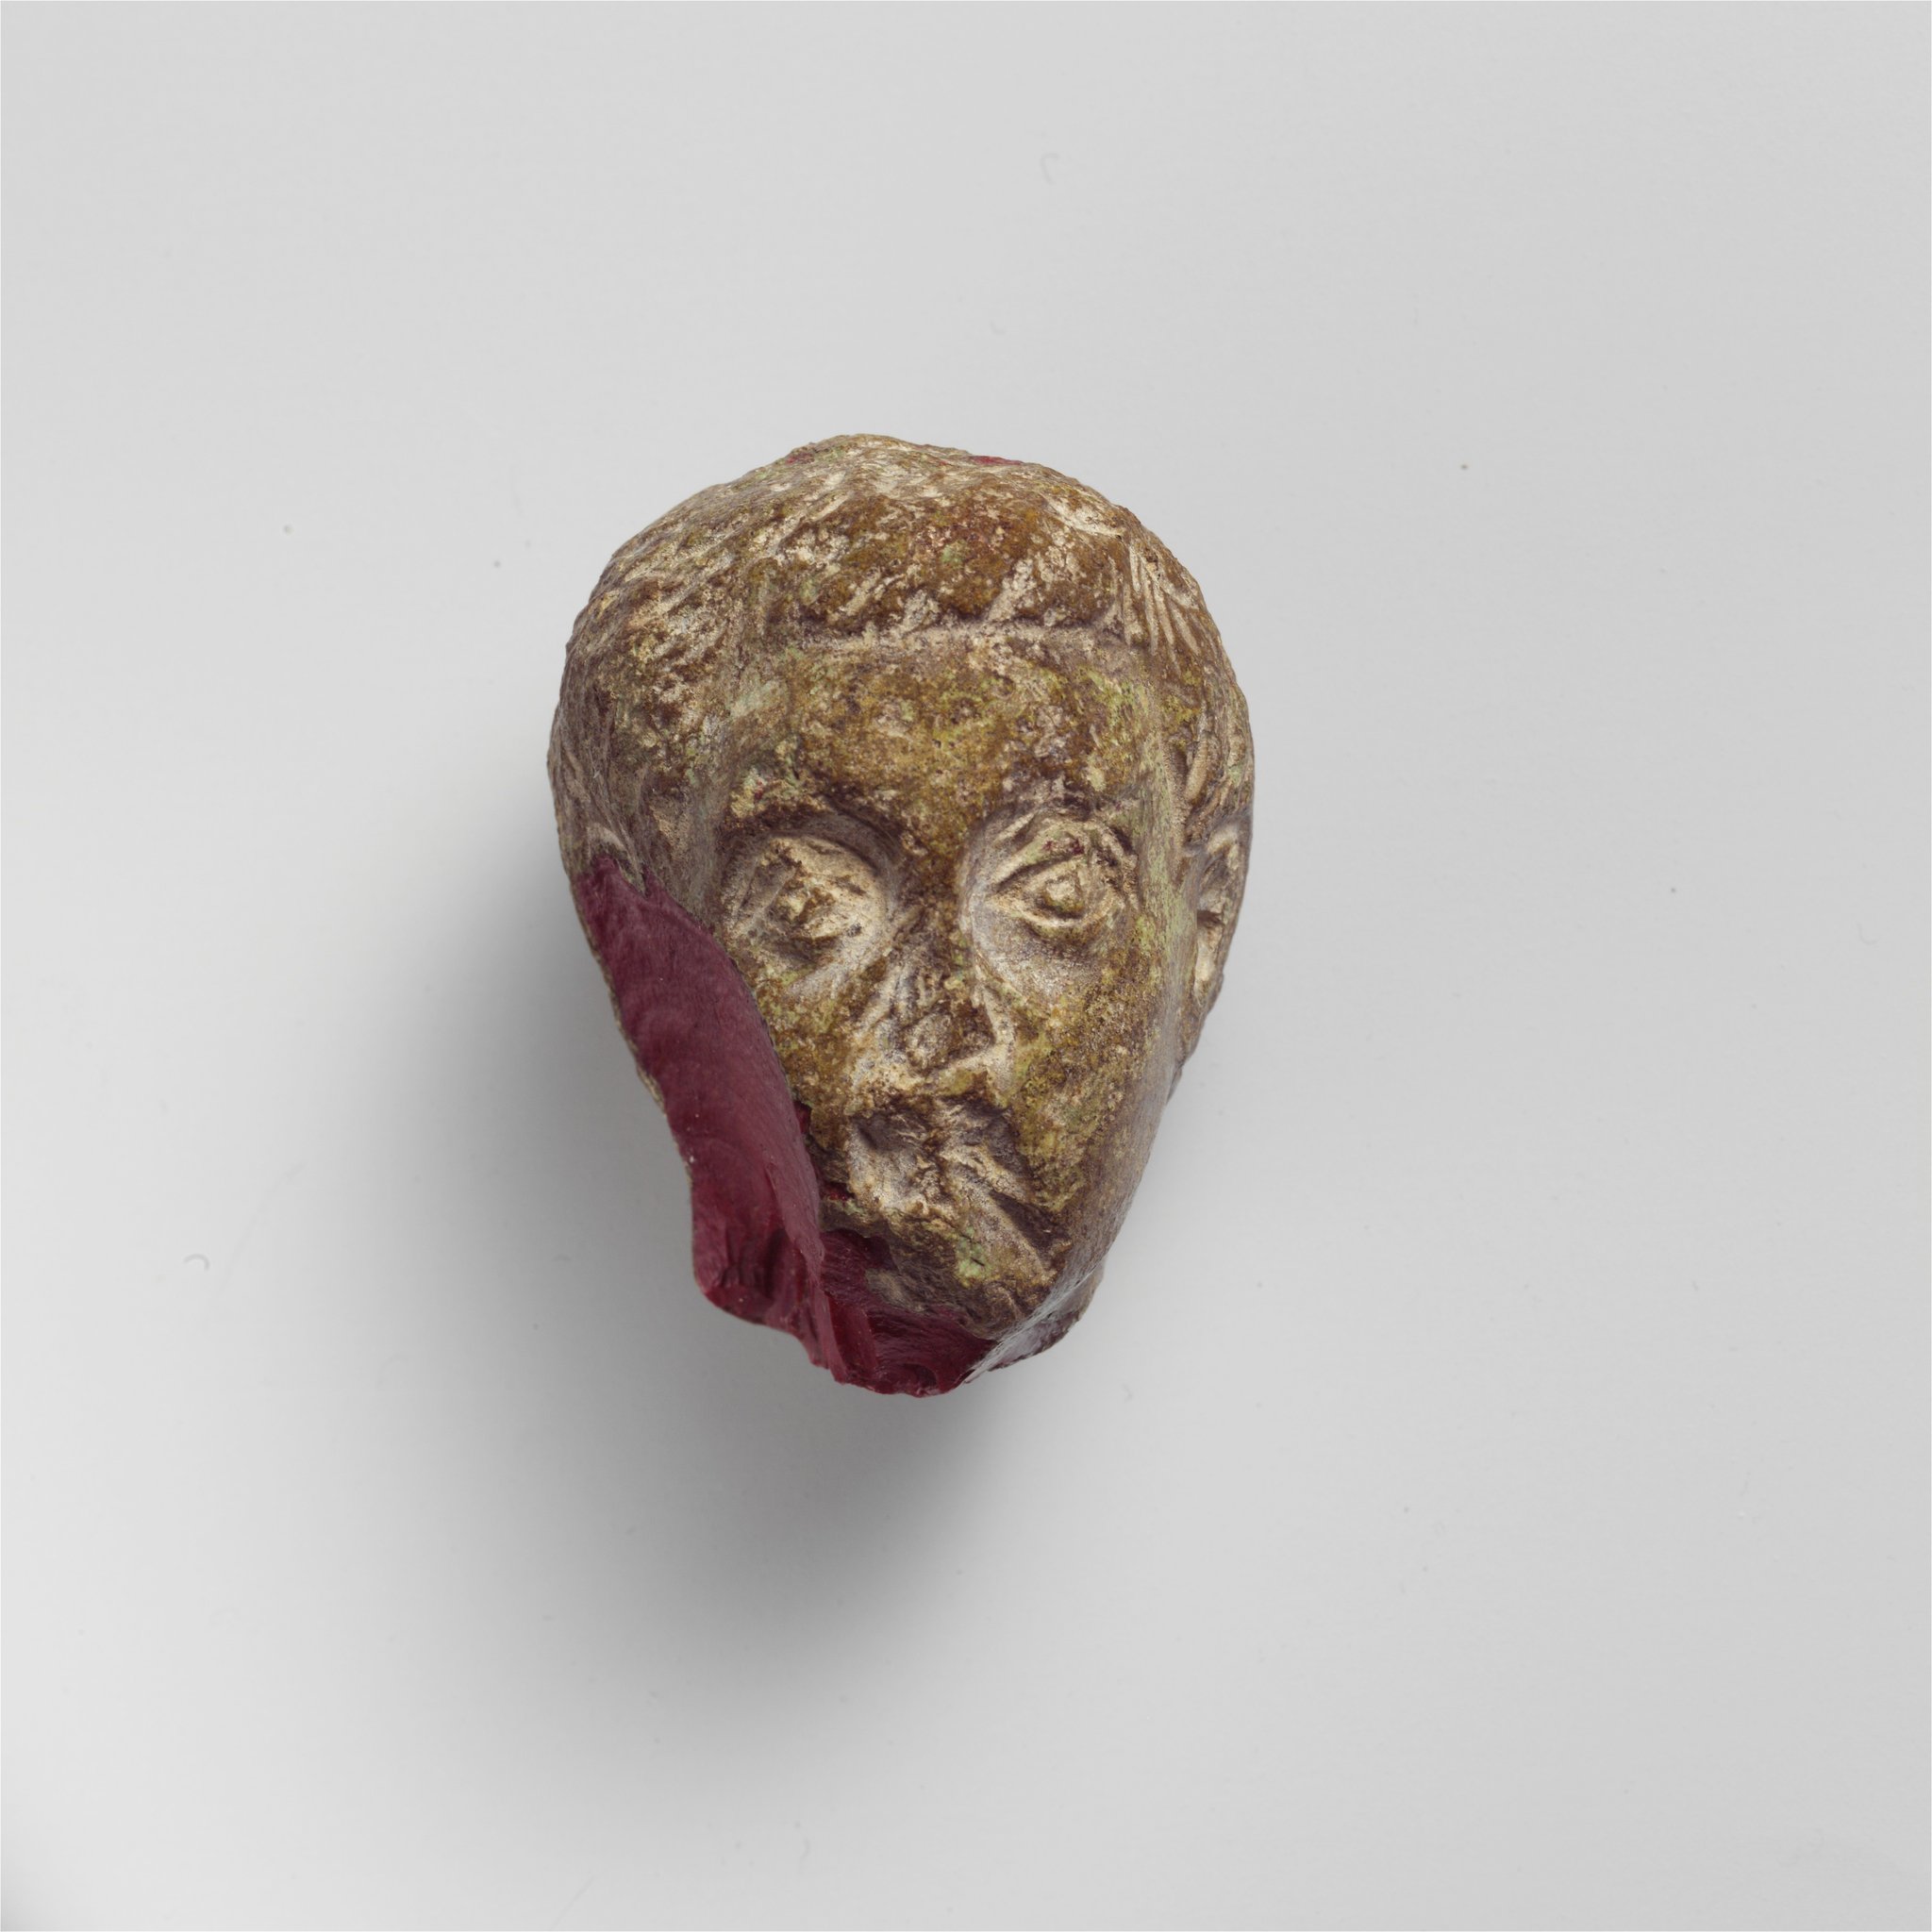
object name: head of a man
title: Glass portrait head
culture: roman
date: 301-350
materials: glass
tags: heads